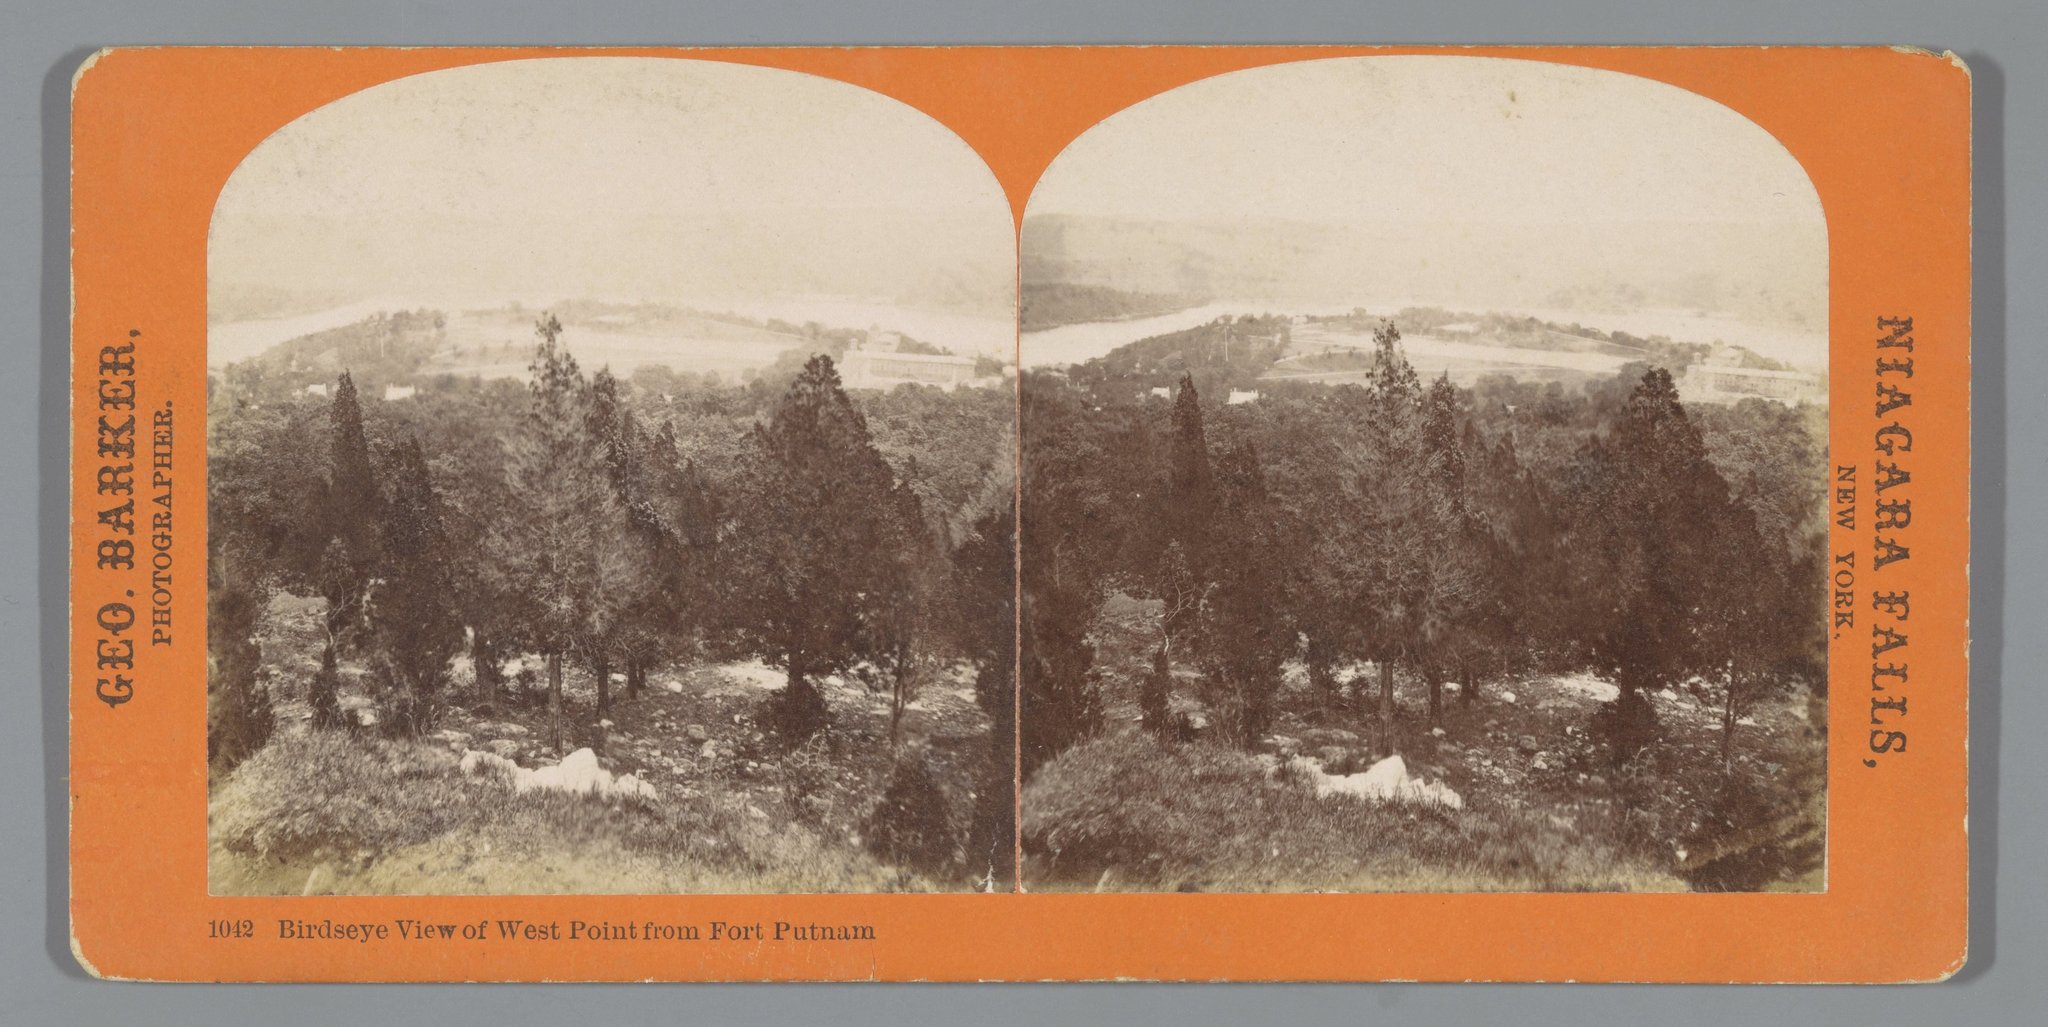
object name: stereograph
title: Birdseye View of West Point from Fort Putnam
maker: george barker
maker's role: fotograaf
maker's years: 1844-1894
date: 1863-1894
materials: cardboard, paper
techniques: albumen print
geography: west point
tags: dale, valley, river, groups of trees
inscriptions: inscription: ‘2/3’, number: ‘1042’